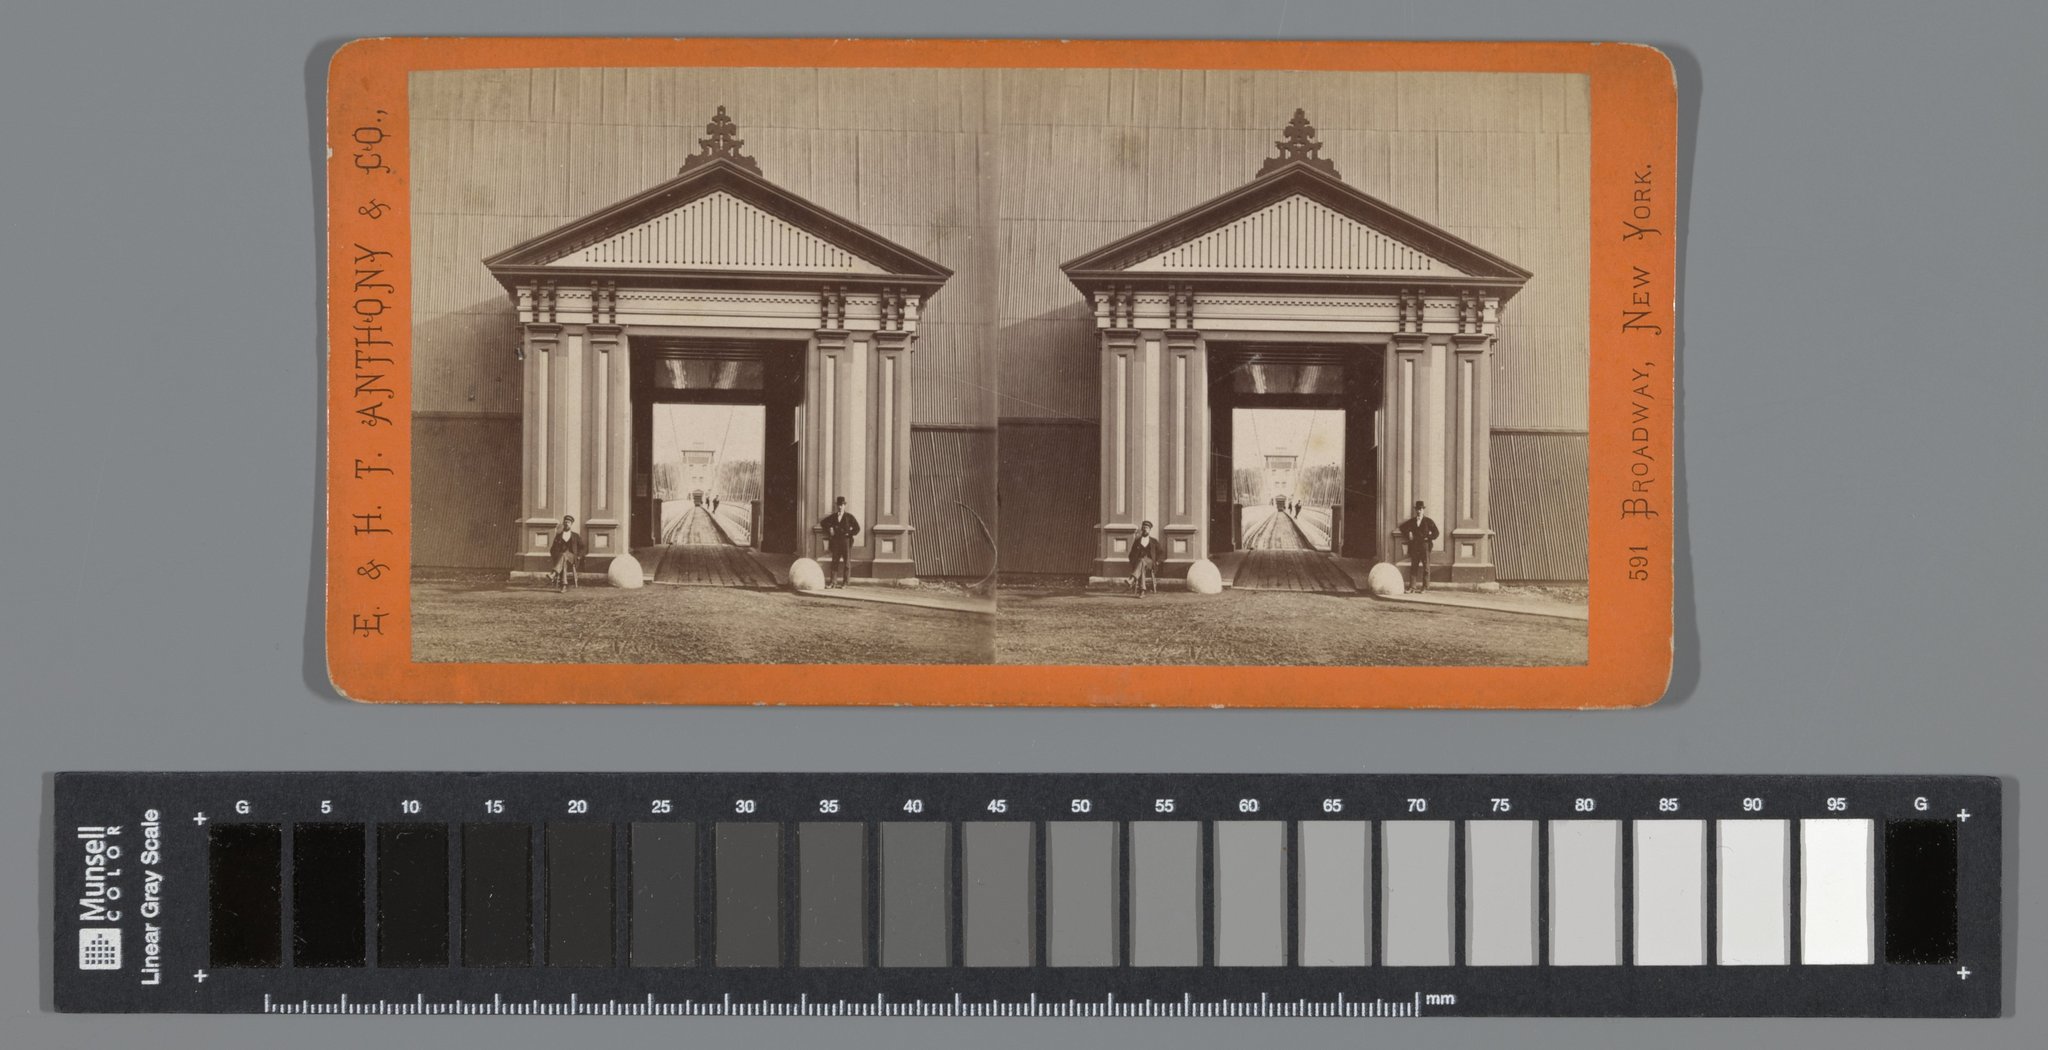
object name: stereograph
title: Entrance to the New Suspension Bridge and Perspective in Niagara Falls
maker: Anonymous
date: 1863-1874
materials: cardboard, paper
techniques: albumen print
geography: niagara clifton bridge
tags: suspension bridge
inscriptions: number: ‘No. 7774,'5.’, address: ‘Emporium of American and Foreign Stereoscopic Views, Chromos and Albums, 591 Broadway, opposite Metropolitan Hotel, New York.’